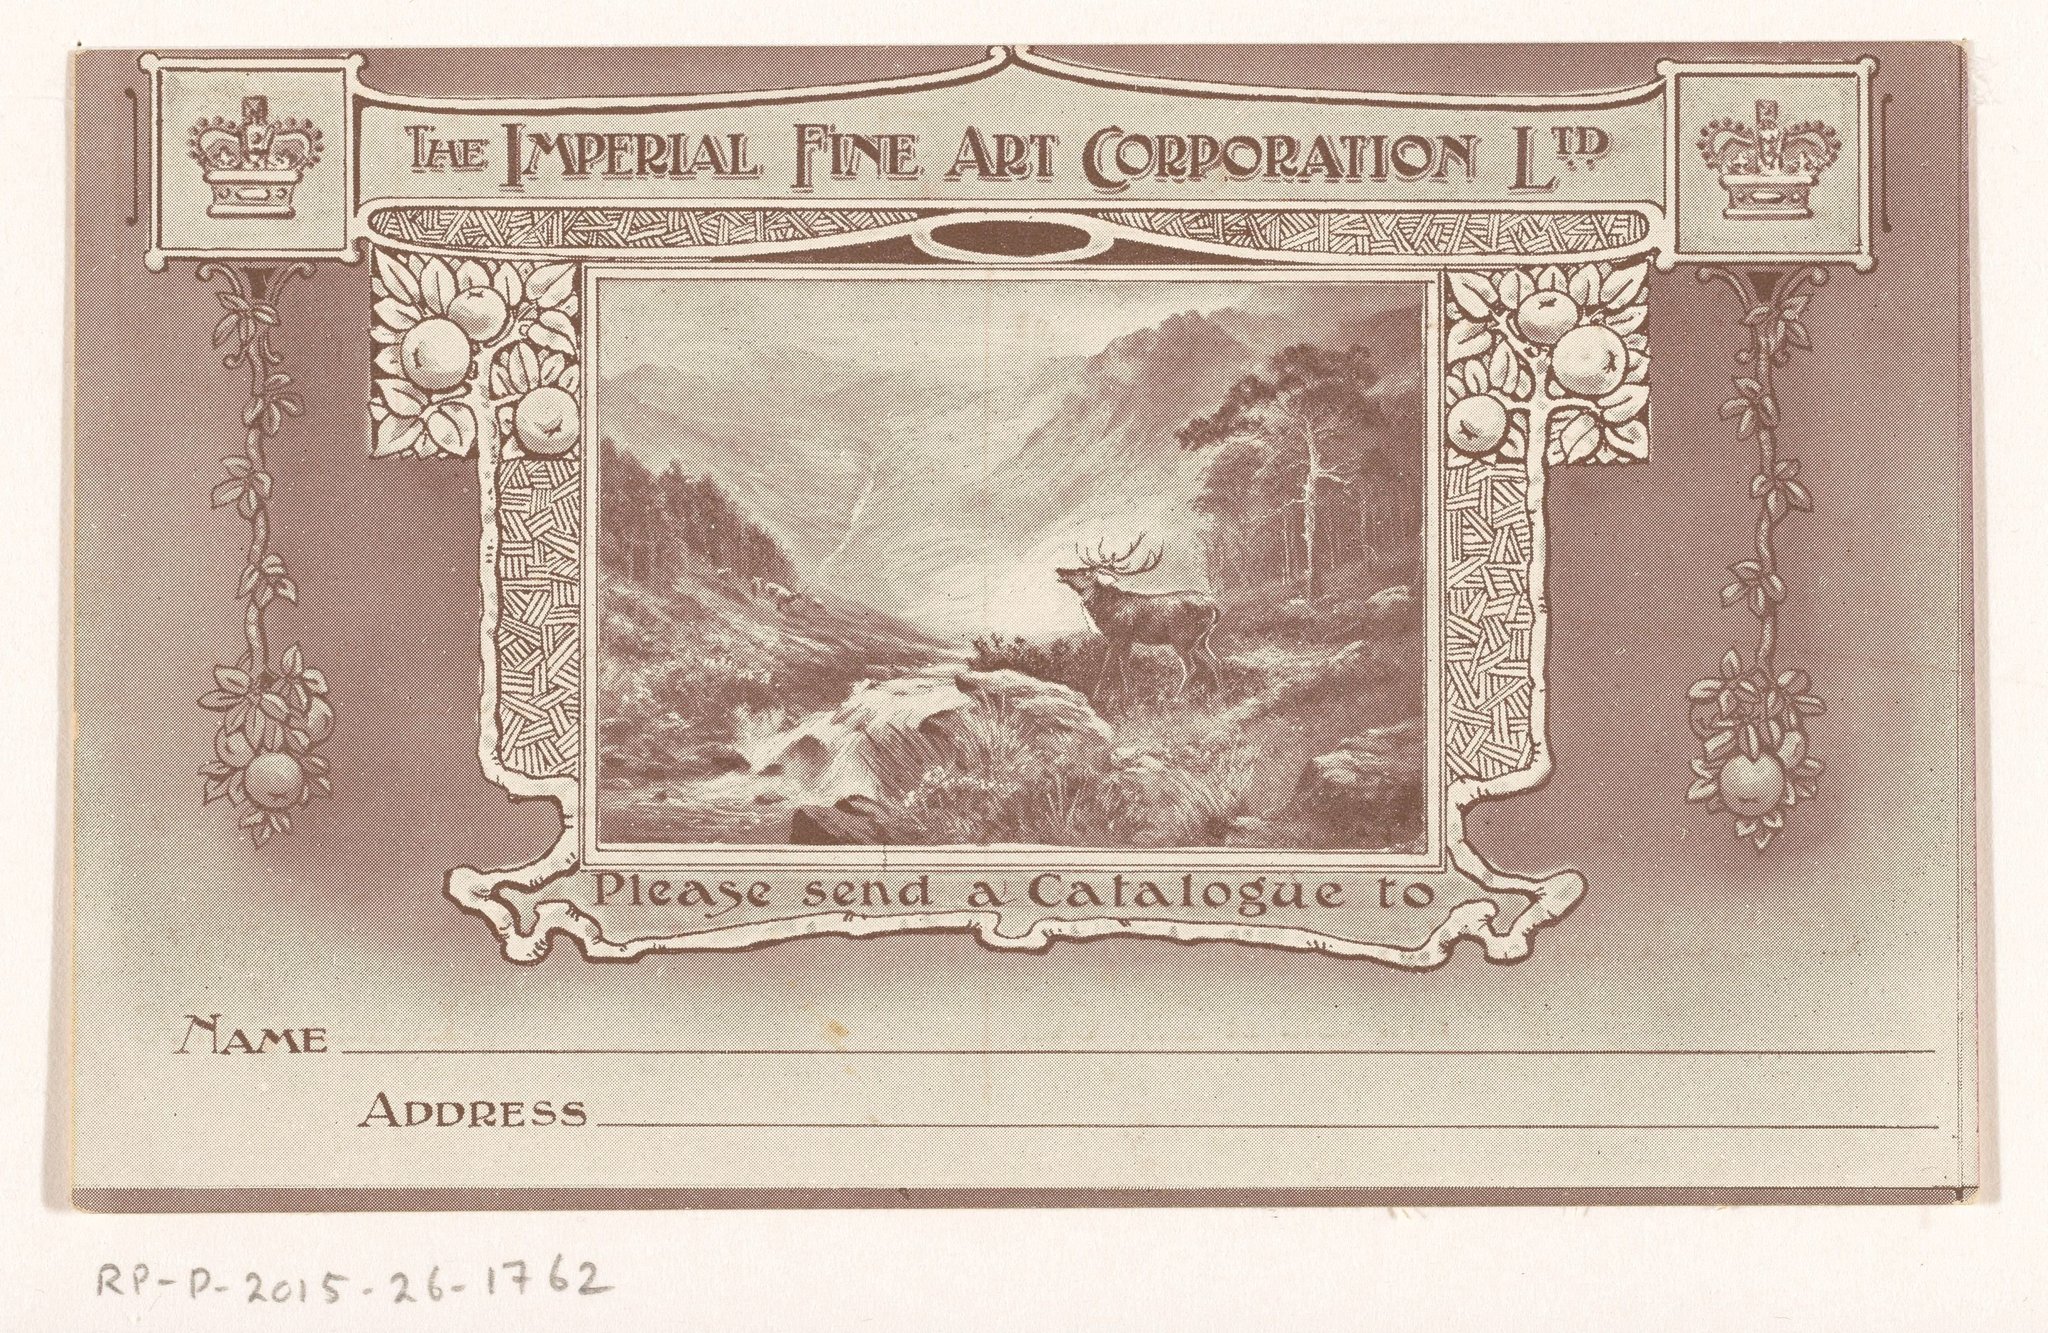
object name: ansichtkaart, prentbriefkaart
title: Bestelkaart van The Imperial Art Corporation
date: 1900-1925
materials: paper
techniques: autotype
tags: hoofed animals: deer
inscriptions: collector's mark: Lugt 2228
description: Schilderij van een hert in een landschap in een omlijsting met fruit en twee kronen.